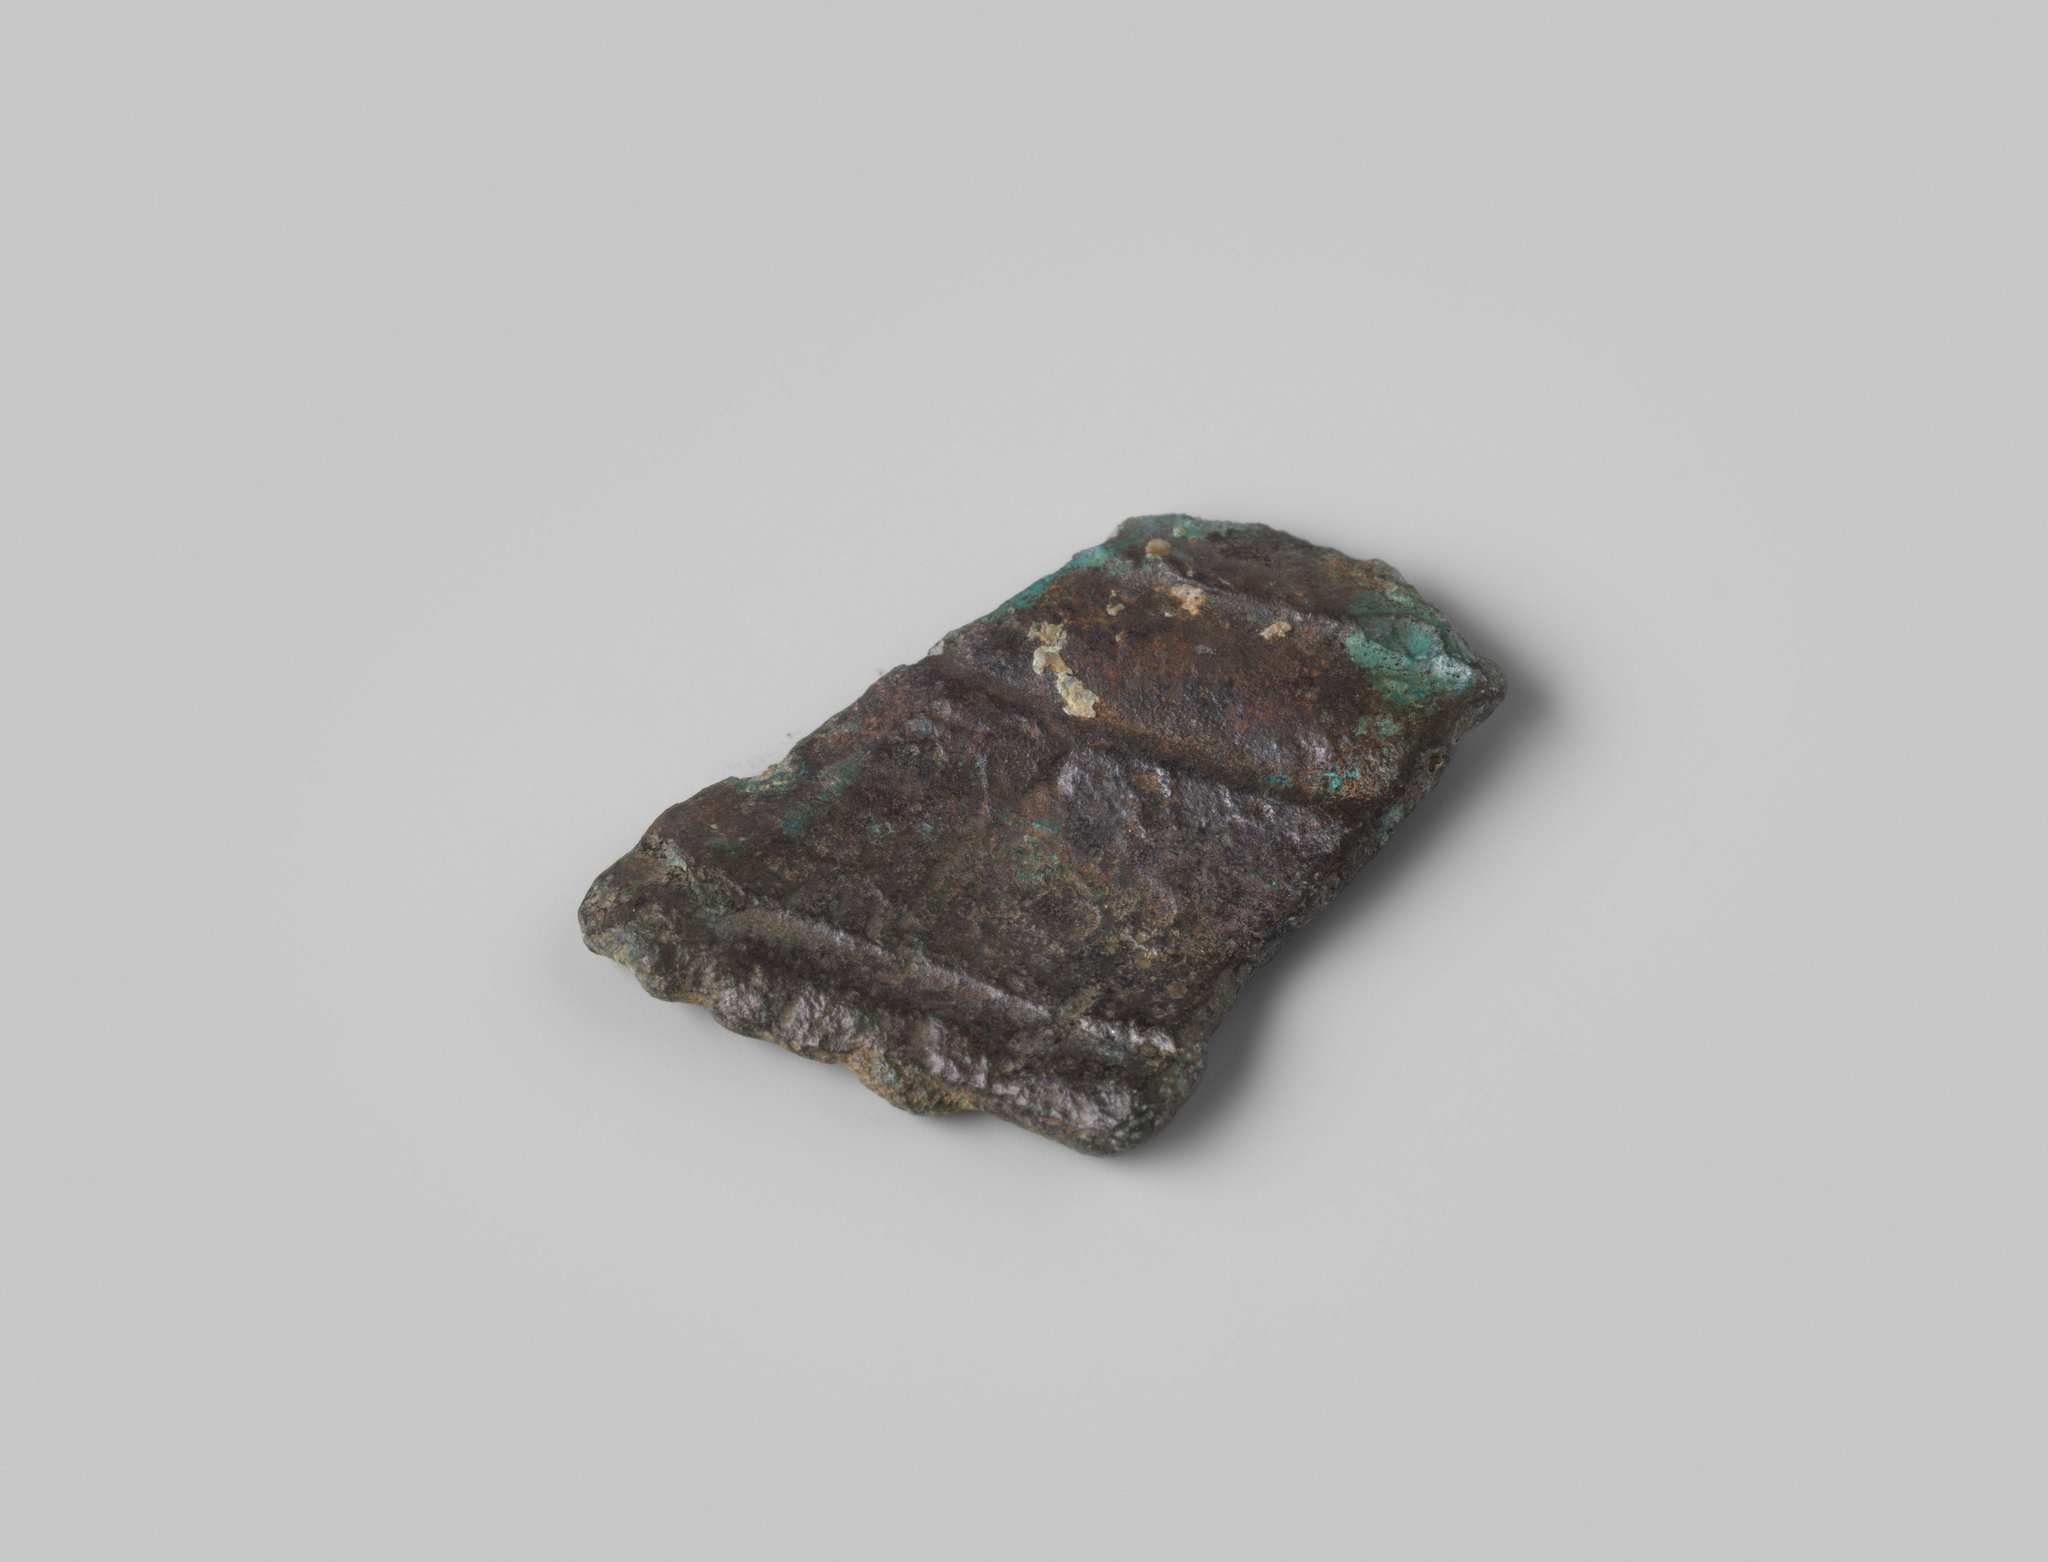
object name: candlestick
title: Fragment voet van een kandelaar uit het wrak van de Oost-Indiëvaarder Hollandia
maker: Anonymous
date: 1700-1743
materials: silver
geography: netherlands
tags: verenigde oostindische compagnie, hollandia (schip), annet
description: Candlestick, foot; fragm, sim. NG 1980-27H118.